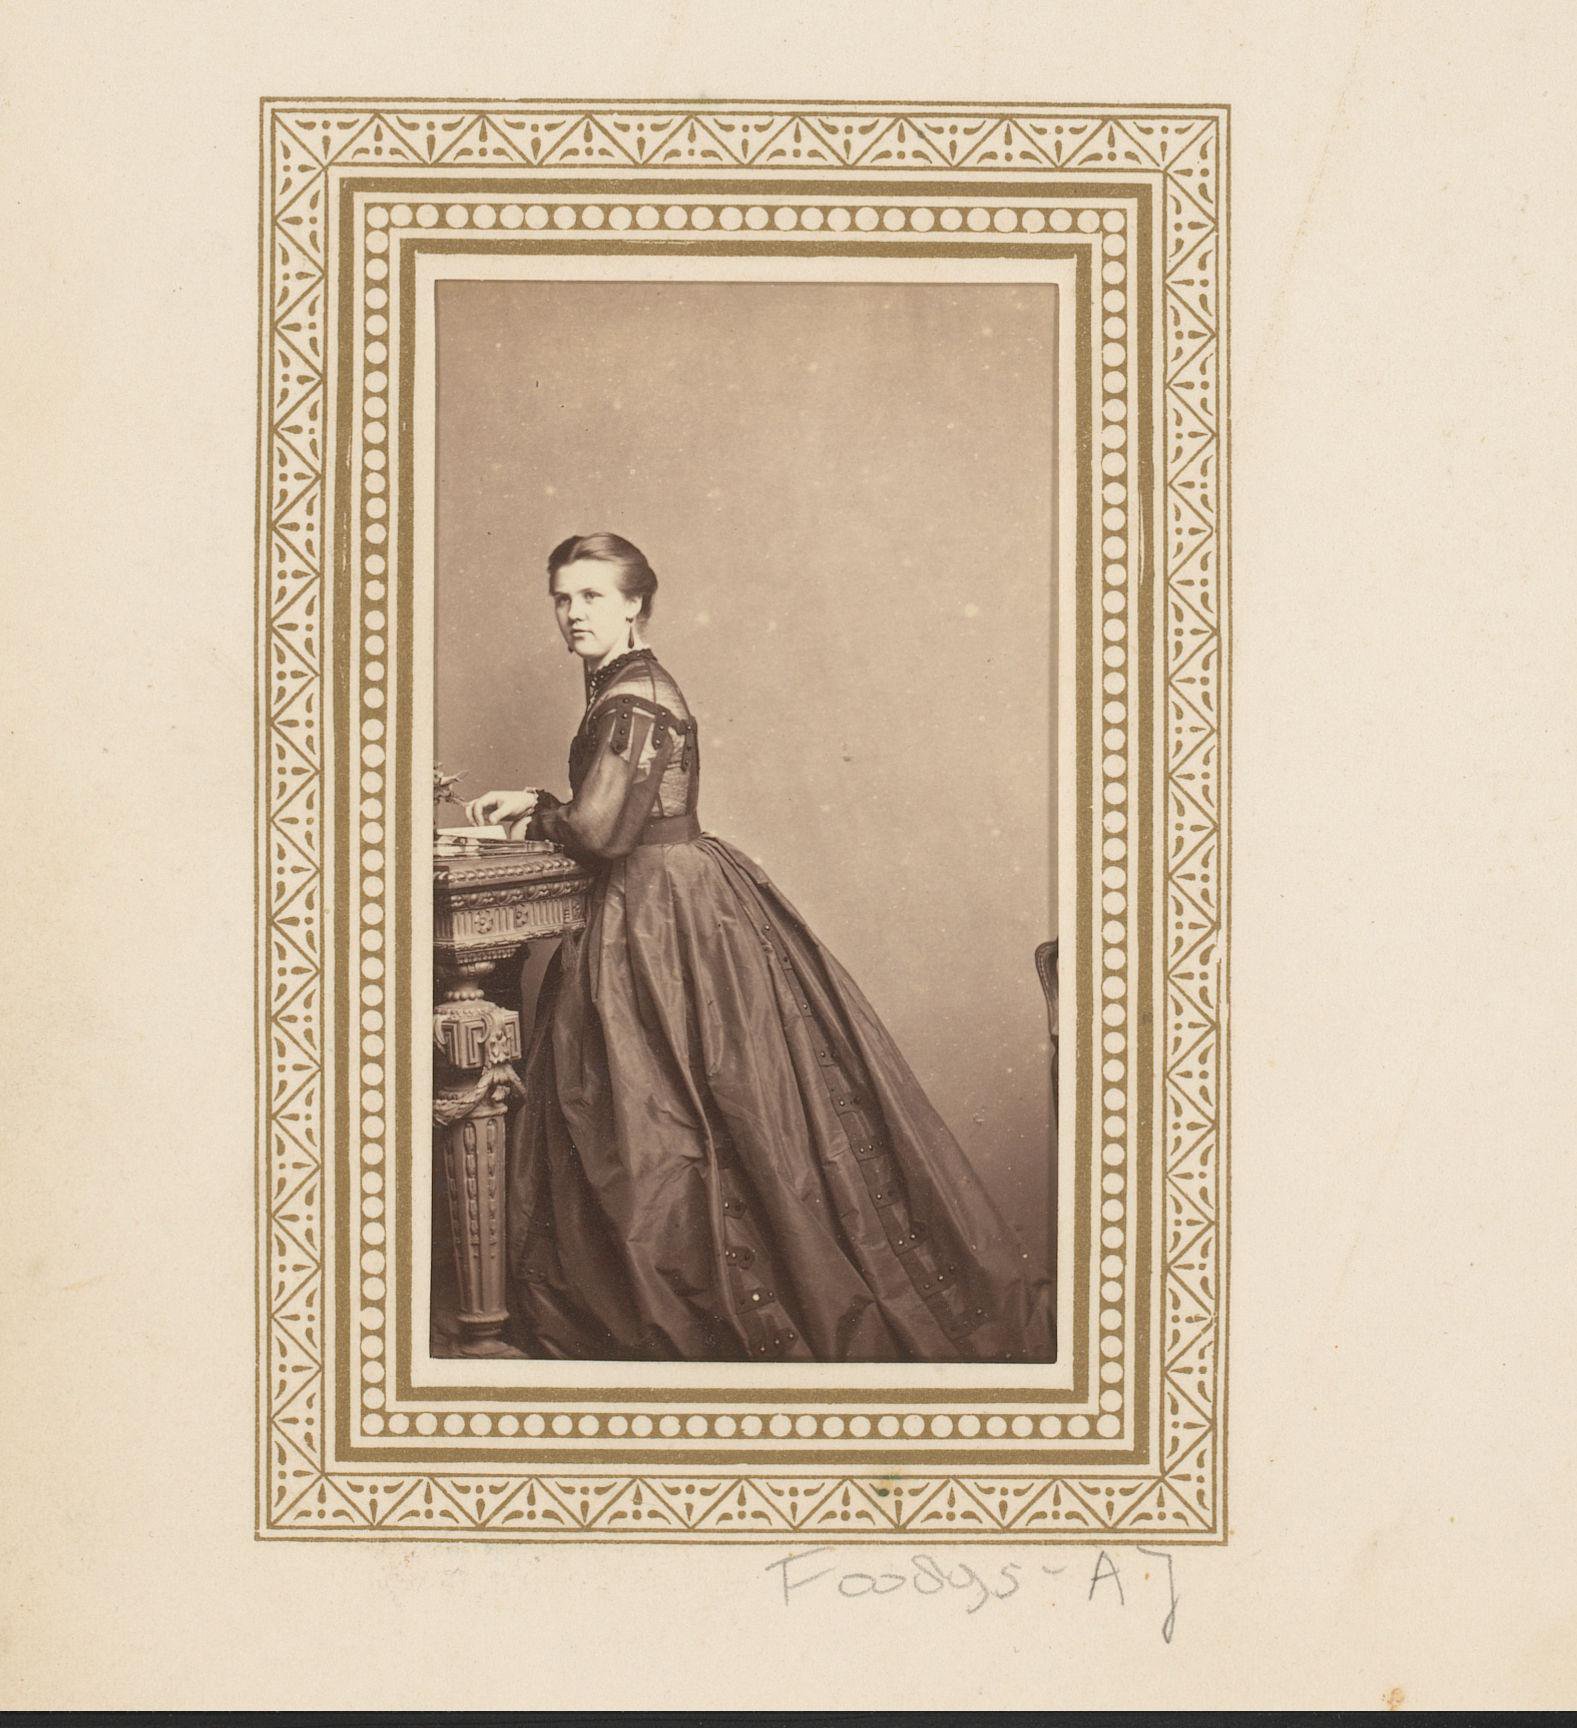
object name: photograph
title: Portret van een vrouw bij een tafel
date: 1867-1880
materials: cardboard, photographic support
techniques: albumen print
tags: adult woman, historical persons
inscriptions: inscription: ‘Photographers & Miniature Painters/ to the Principal Souvereigns of Europe/ Moira & Haigh/ L. Lower Seymour Street Portman Sq. W./ opposite the Marylebone Institution’